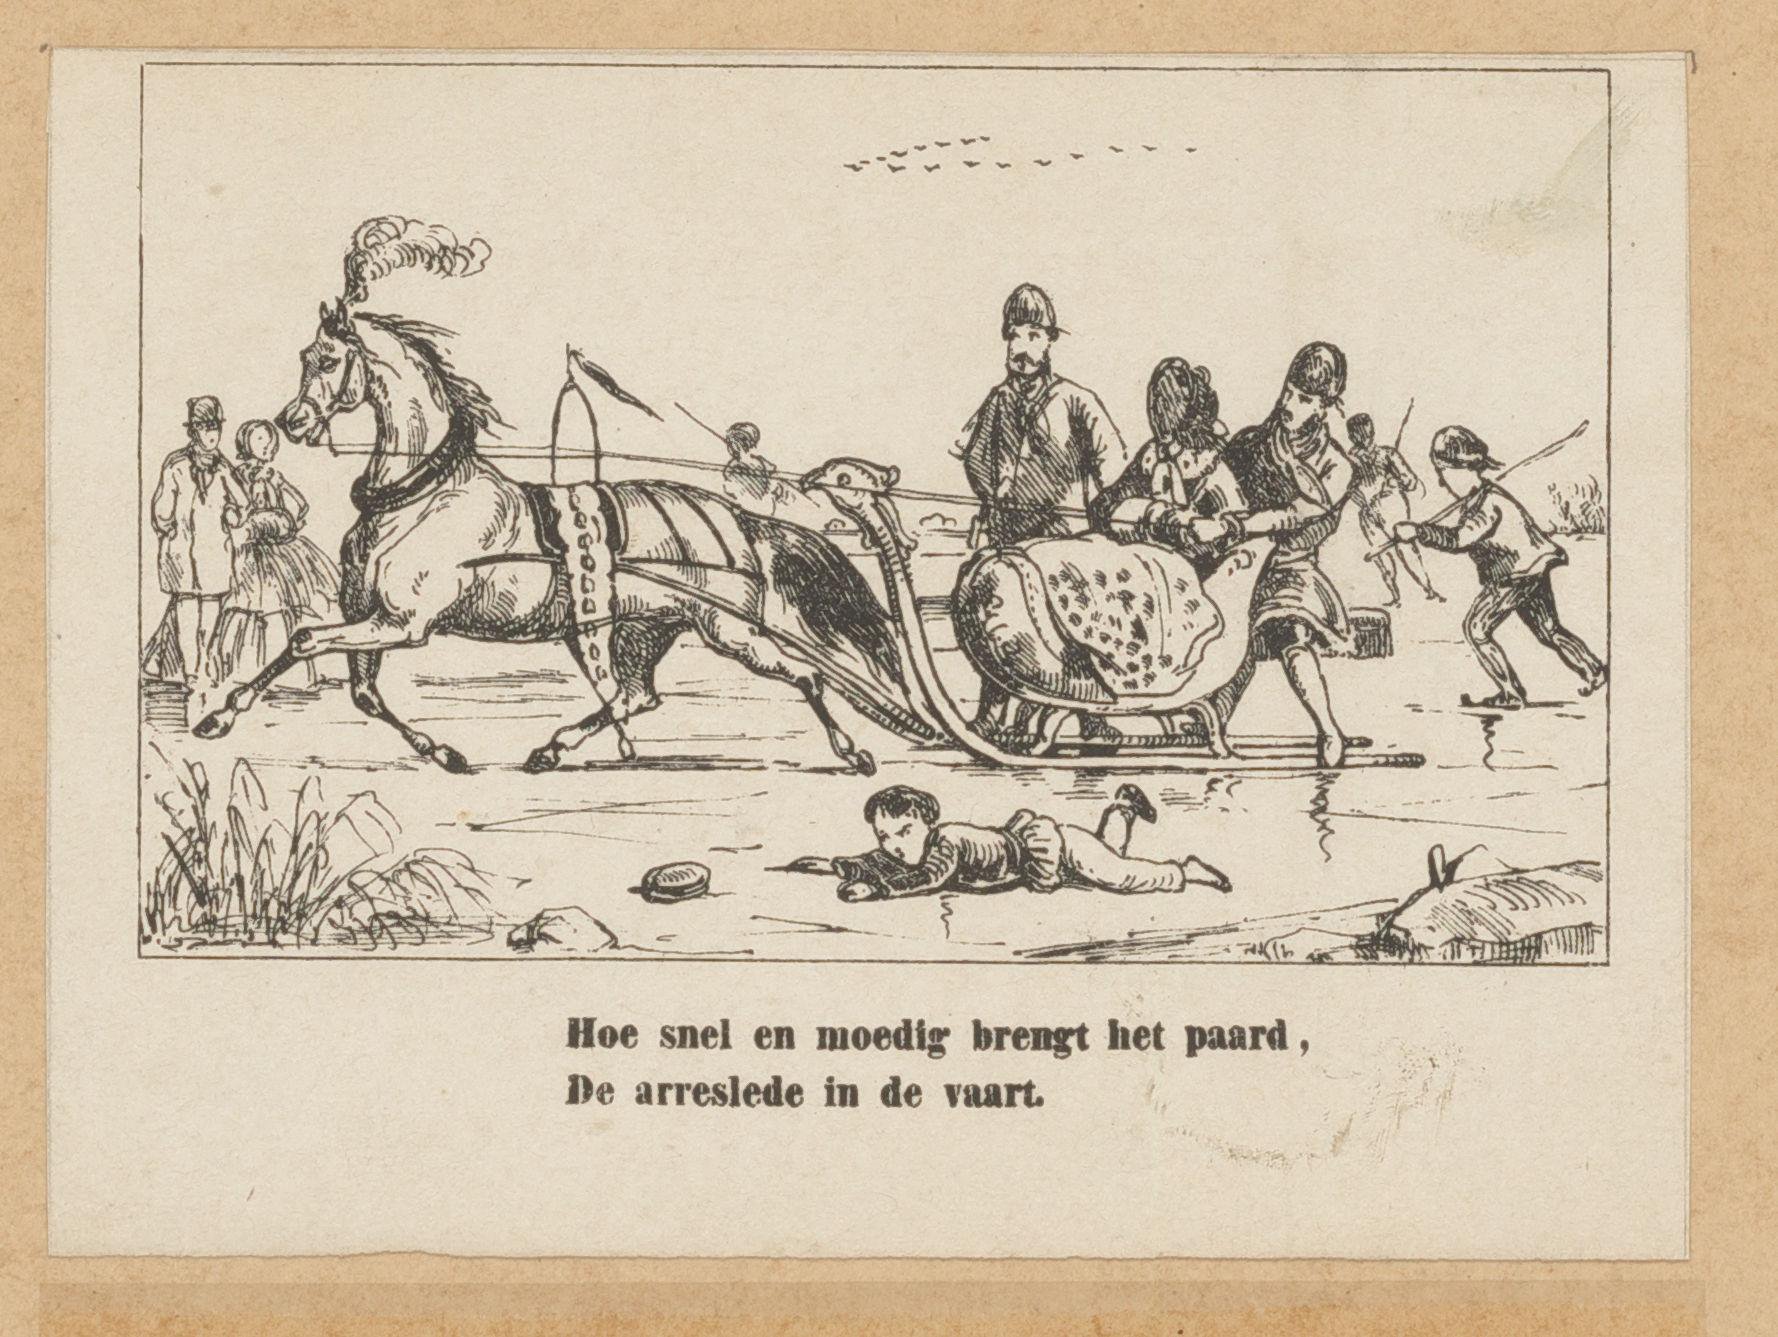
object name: print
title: Hoe snel en moedig brengt het paard, de arreslede in de vaart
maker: Anonymous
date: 1800-1899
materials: paper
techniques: lithograph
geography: netherlands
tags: horse-sleigh, winter sports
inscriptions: collector's mark, collector's mark: Lugt 1641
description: Arrenslede op het ijs. Onderwerpsrubrieken binnen de Atlas Zeden en Gewoonten: Spel en Vermaak; IJsvermaak, Sleden.